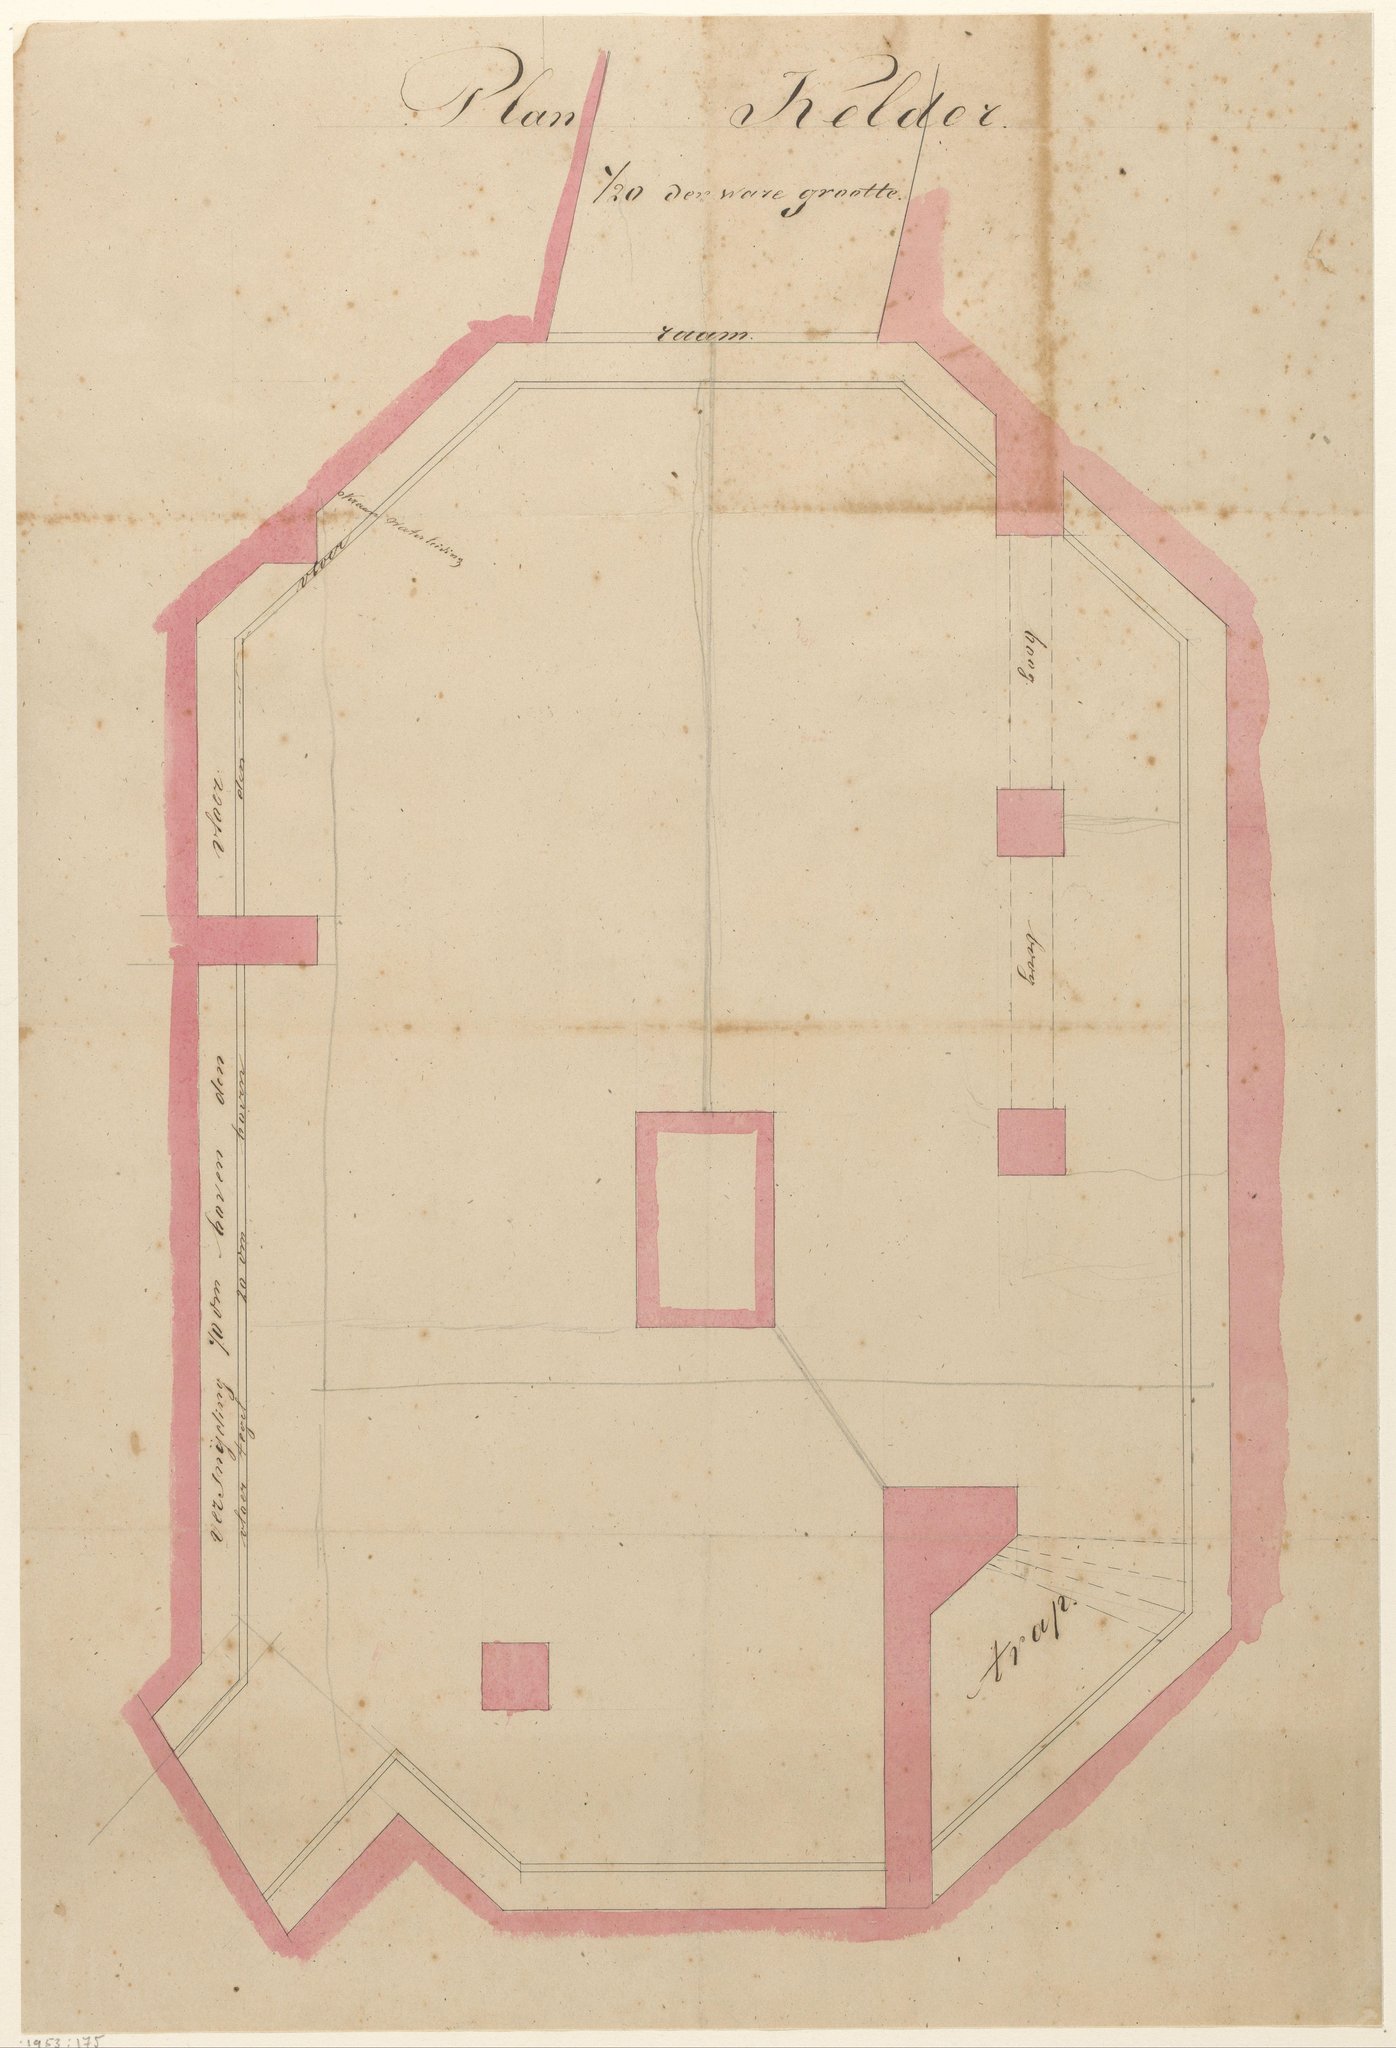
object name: drawing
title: Plattegrond van de kelder onder de achthoekige zaal in het huis op de Nieuwe Gracht, laatstelijk bewoond door Jhr. Teding van Berkhout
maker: Anonymous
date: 1820-1825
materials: ink, paper, pencil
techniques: brush, pen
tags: plan ~ architecture, basement, cellar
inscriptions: collector's mark: Lugt 2228, inscription: ‘Plan Kelder. (...) trap’